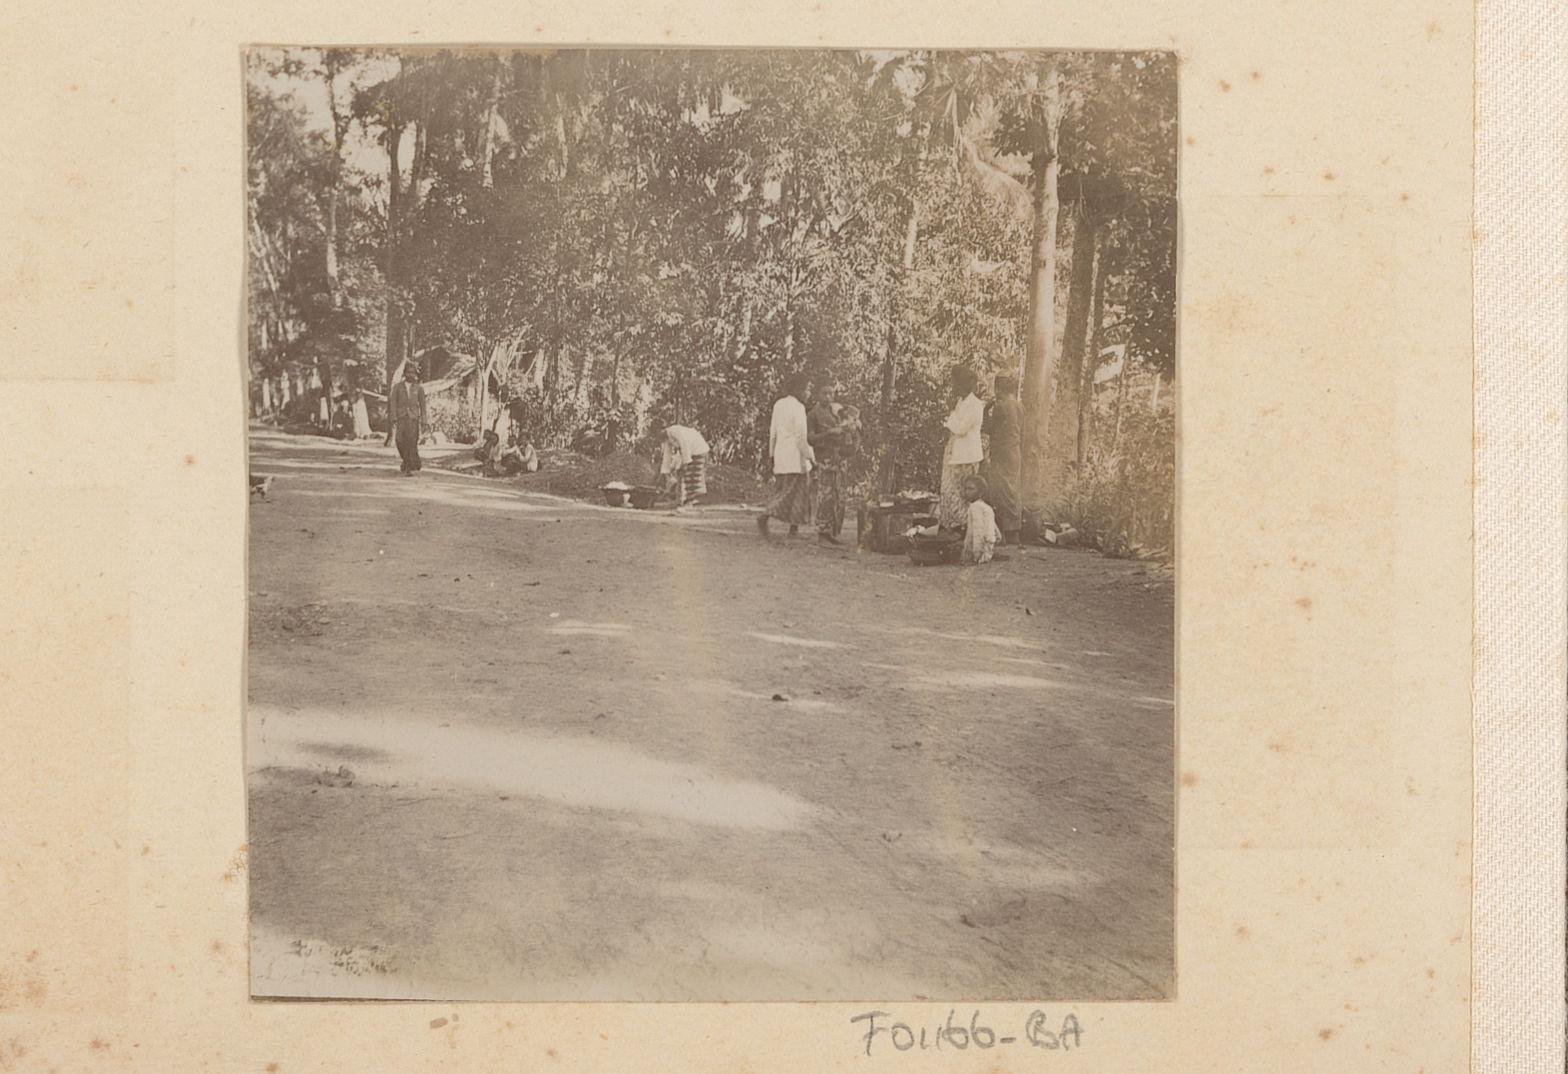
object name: photograph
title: Nederlands-Indië, inlanders met manden langs weg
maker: Anonymous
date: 1895-1910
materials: photographic support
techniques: gelatin silver print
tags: asiatic races and peoples (indonesians), historical persons, road, path, dutch east indies, the